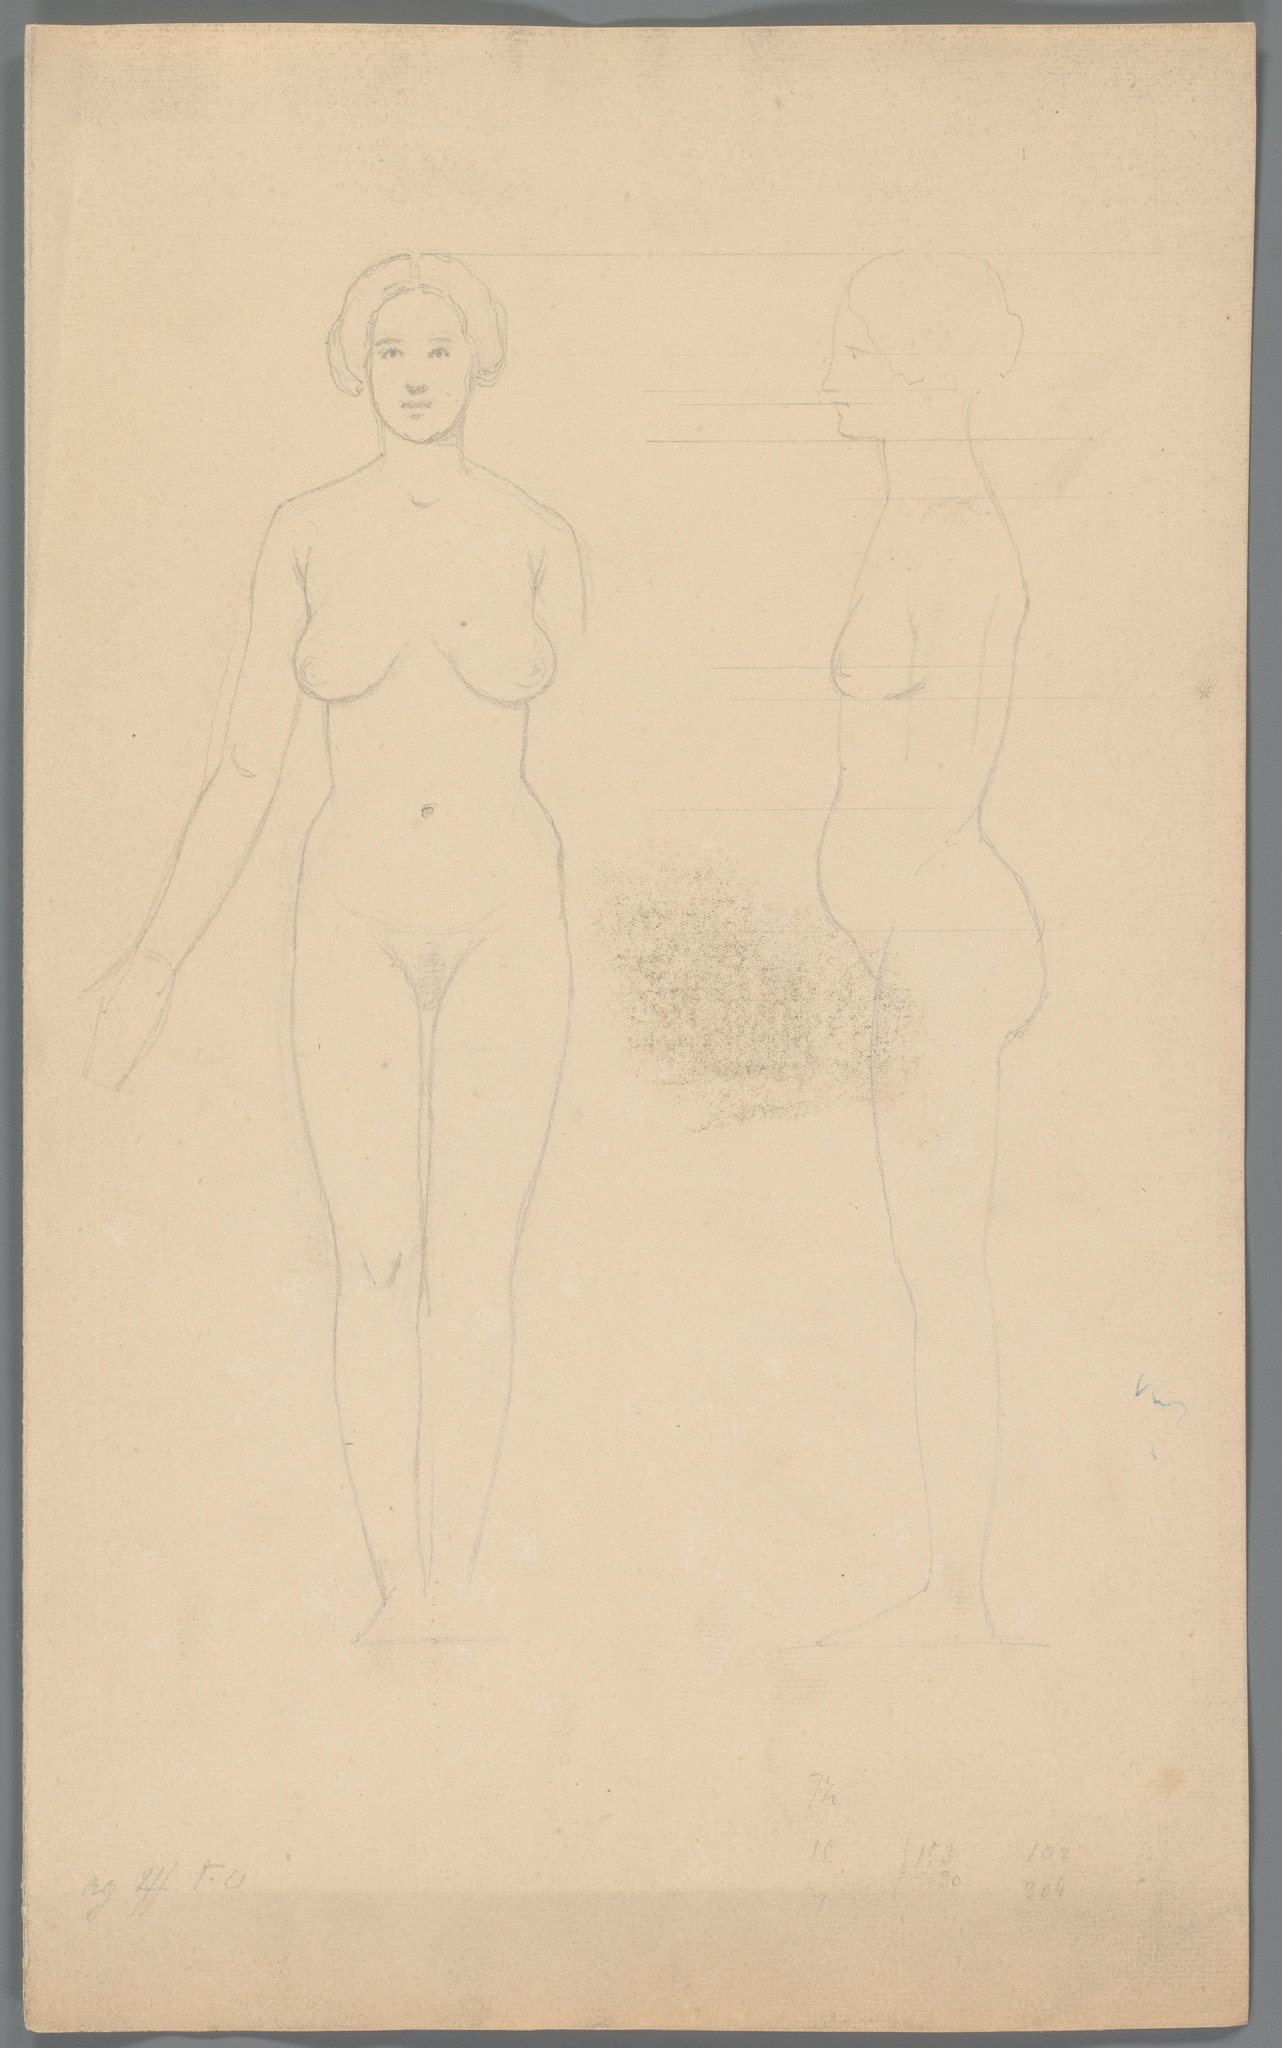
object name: drawing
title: Proportiestudie van een vrouw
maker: jacobus everhardus josephus van den berg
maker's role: draughtsman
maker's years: 1802-1861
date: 1812-1861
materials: paper, pencil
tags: standing figure (canon, proportions) - aa - female human figure, human figure of ideal proportions, e.g. academic nude - aa - female human figure